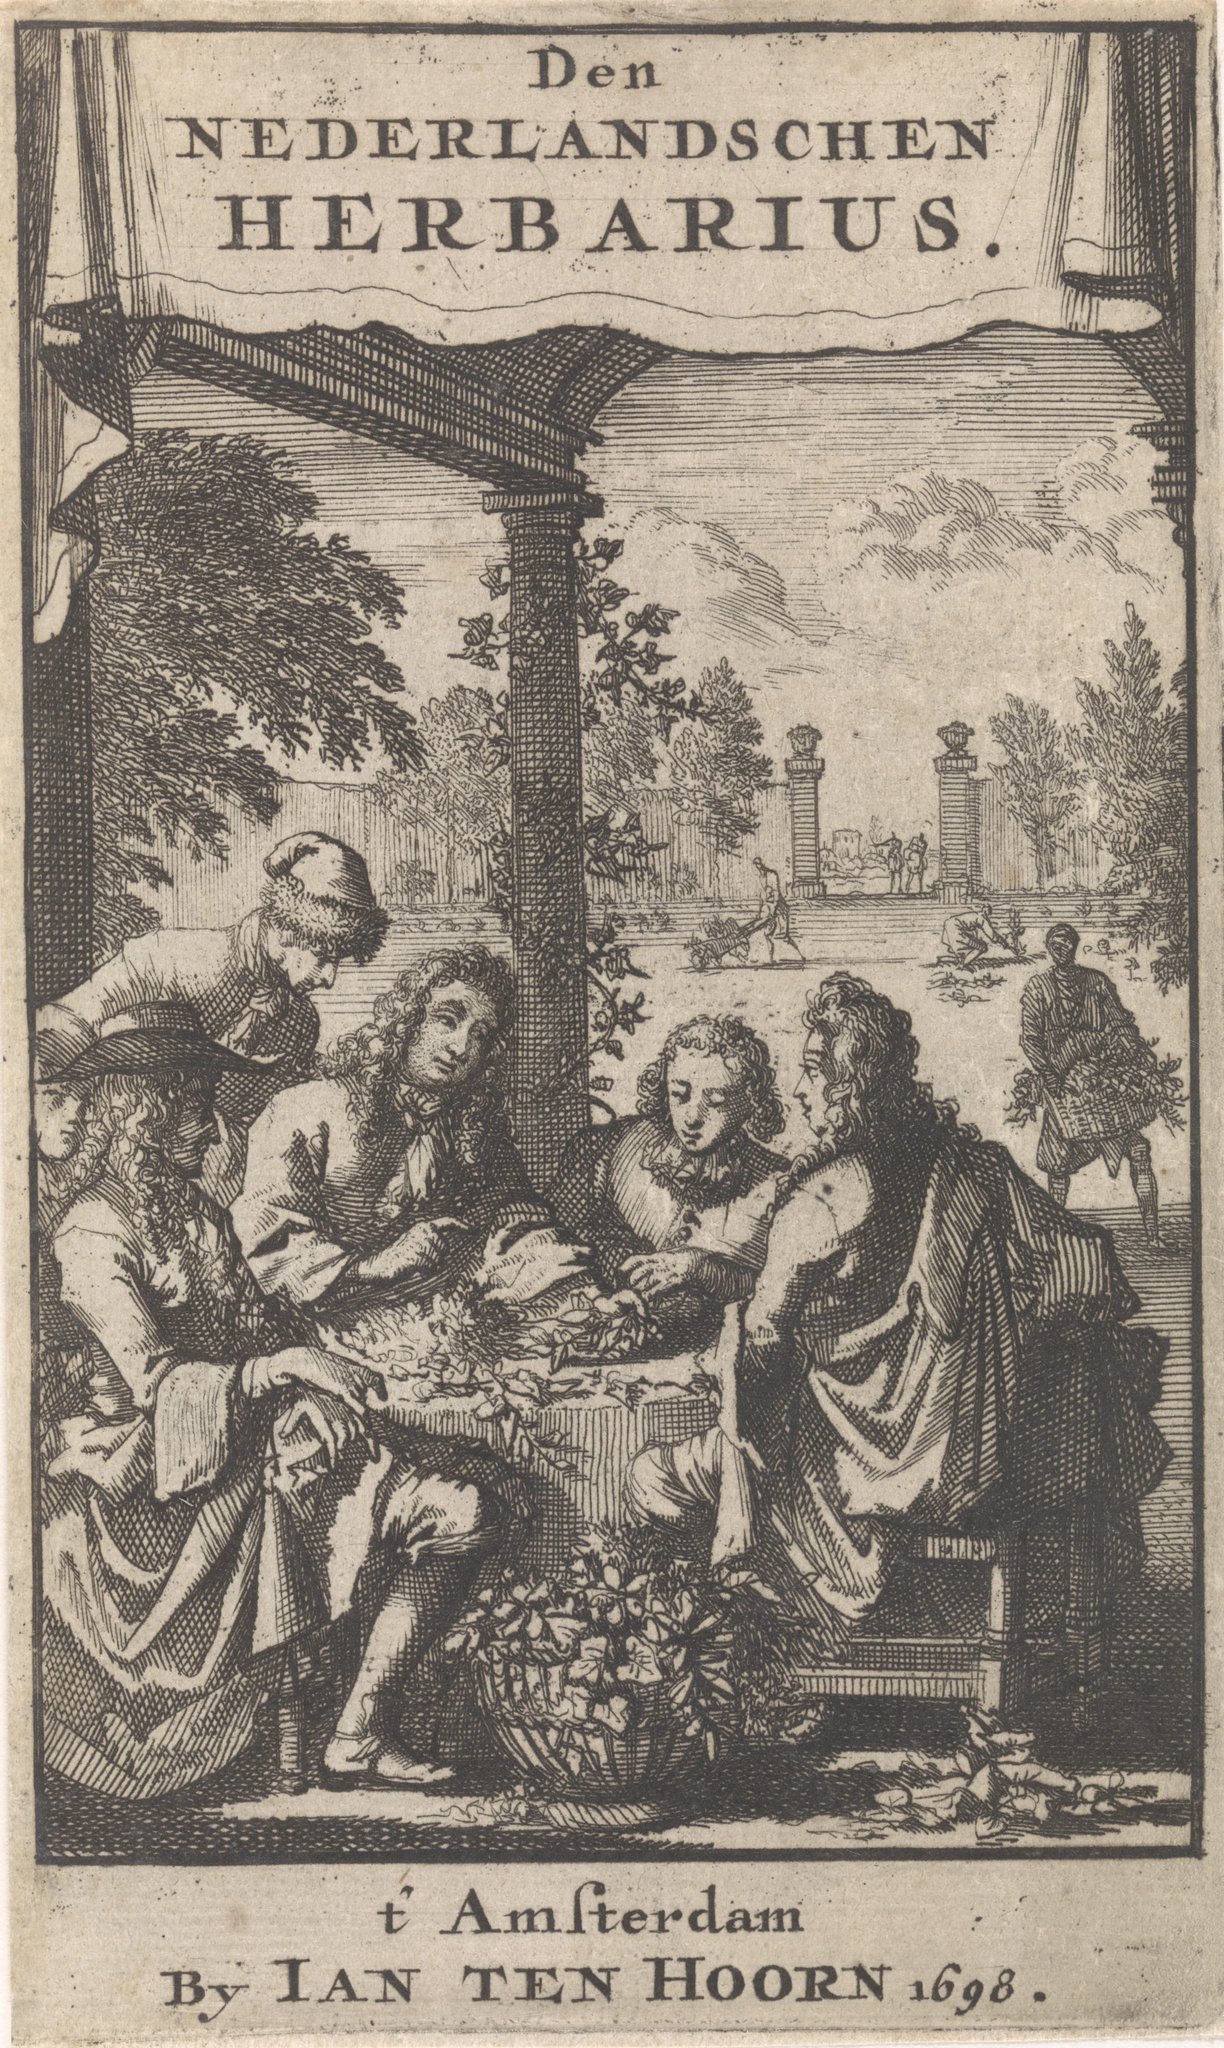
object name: titelblad, titelpagina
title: Title Page and Eight Prints with Flowers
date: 1698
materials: paper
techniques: etching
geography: amsterdam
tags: plants and herbs, botanic garden, 'hortus botanicus' (+ scholar, scientist (at work))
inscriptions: collector's mark: Lugt 2228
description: These floral prints by Jan Luyken are from the Nederlandschen Herbarius published by the physician Steven Blankaart in 1698. This Dutch herbal describes indigenous plants and trees with their medicinal properties. Incidentally, not all flowers had a practical medical application. But they were quite suitable ‘to make nosegays and posies’ or ‘simply a pleasure to look at’.